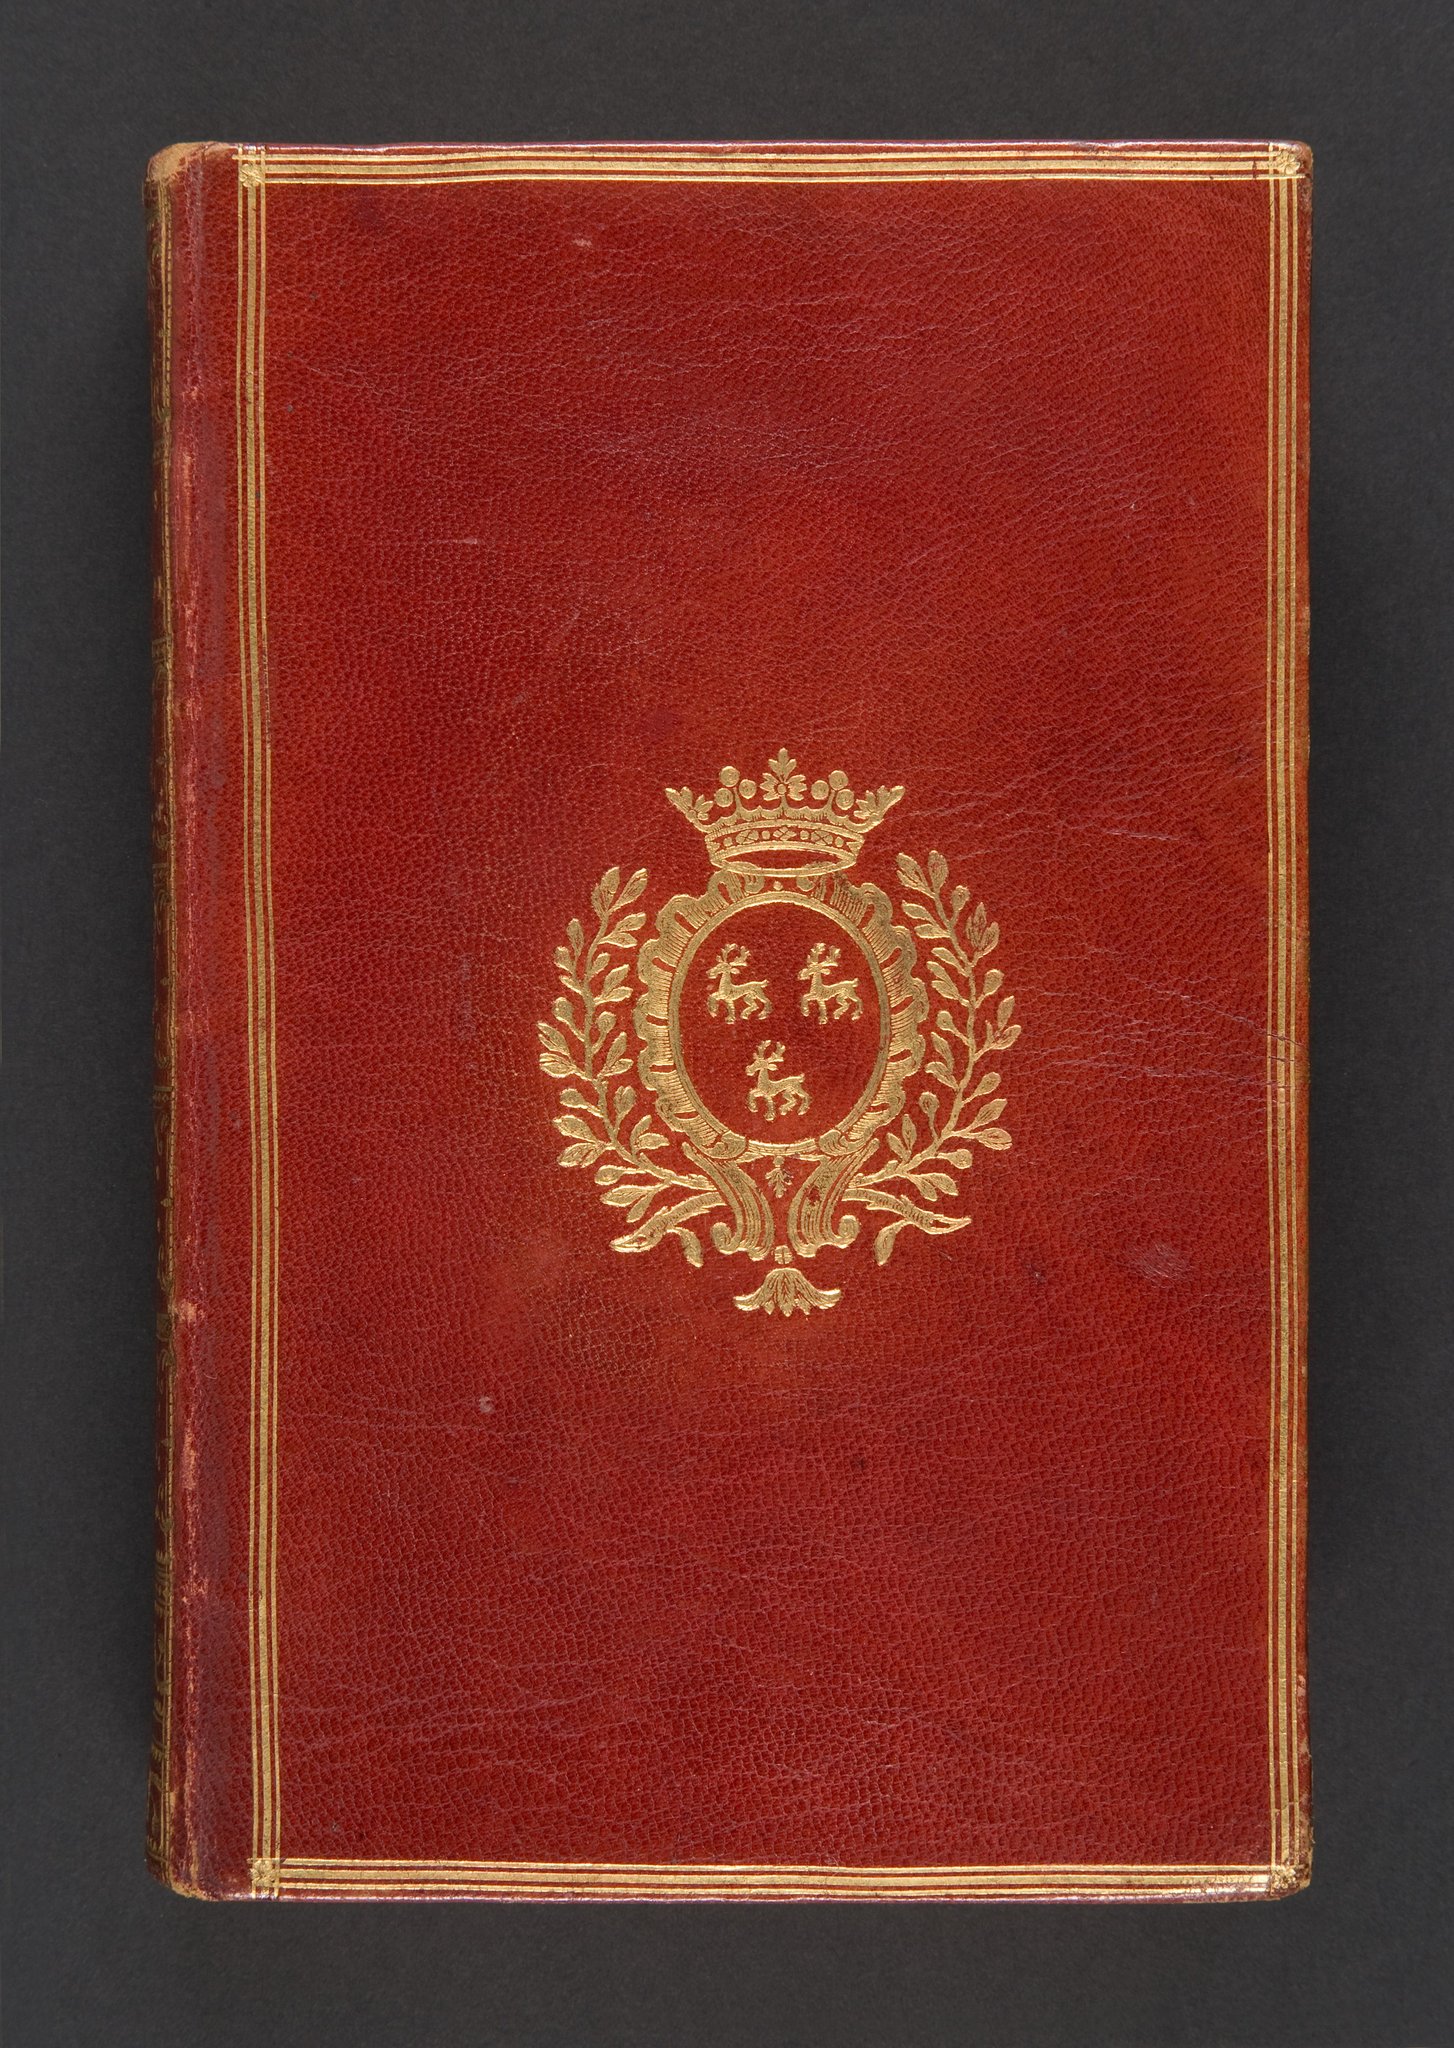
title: L'art de former les jardins modernes, ou, L'art des jardins anglois : traduit de l'anglois : à quoi le traducteur a ajouté un discours préliminaire sur l'origine de l'art, des notes sur le texte, & une description détaillée des jardins de Stowe, accompagnée du plan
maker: charles antoine jombert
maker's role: publisher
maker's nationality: french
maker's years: 1712-1784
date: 1771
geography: france